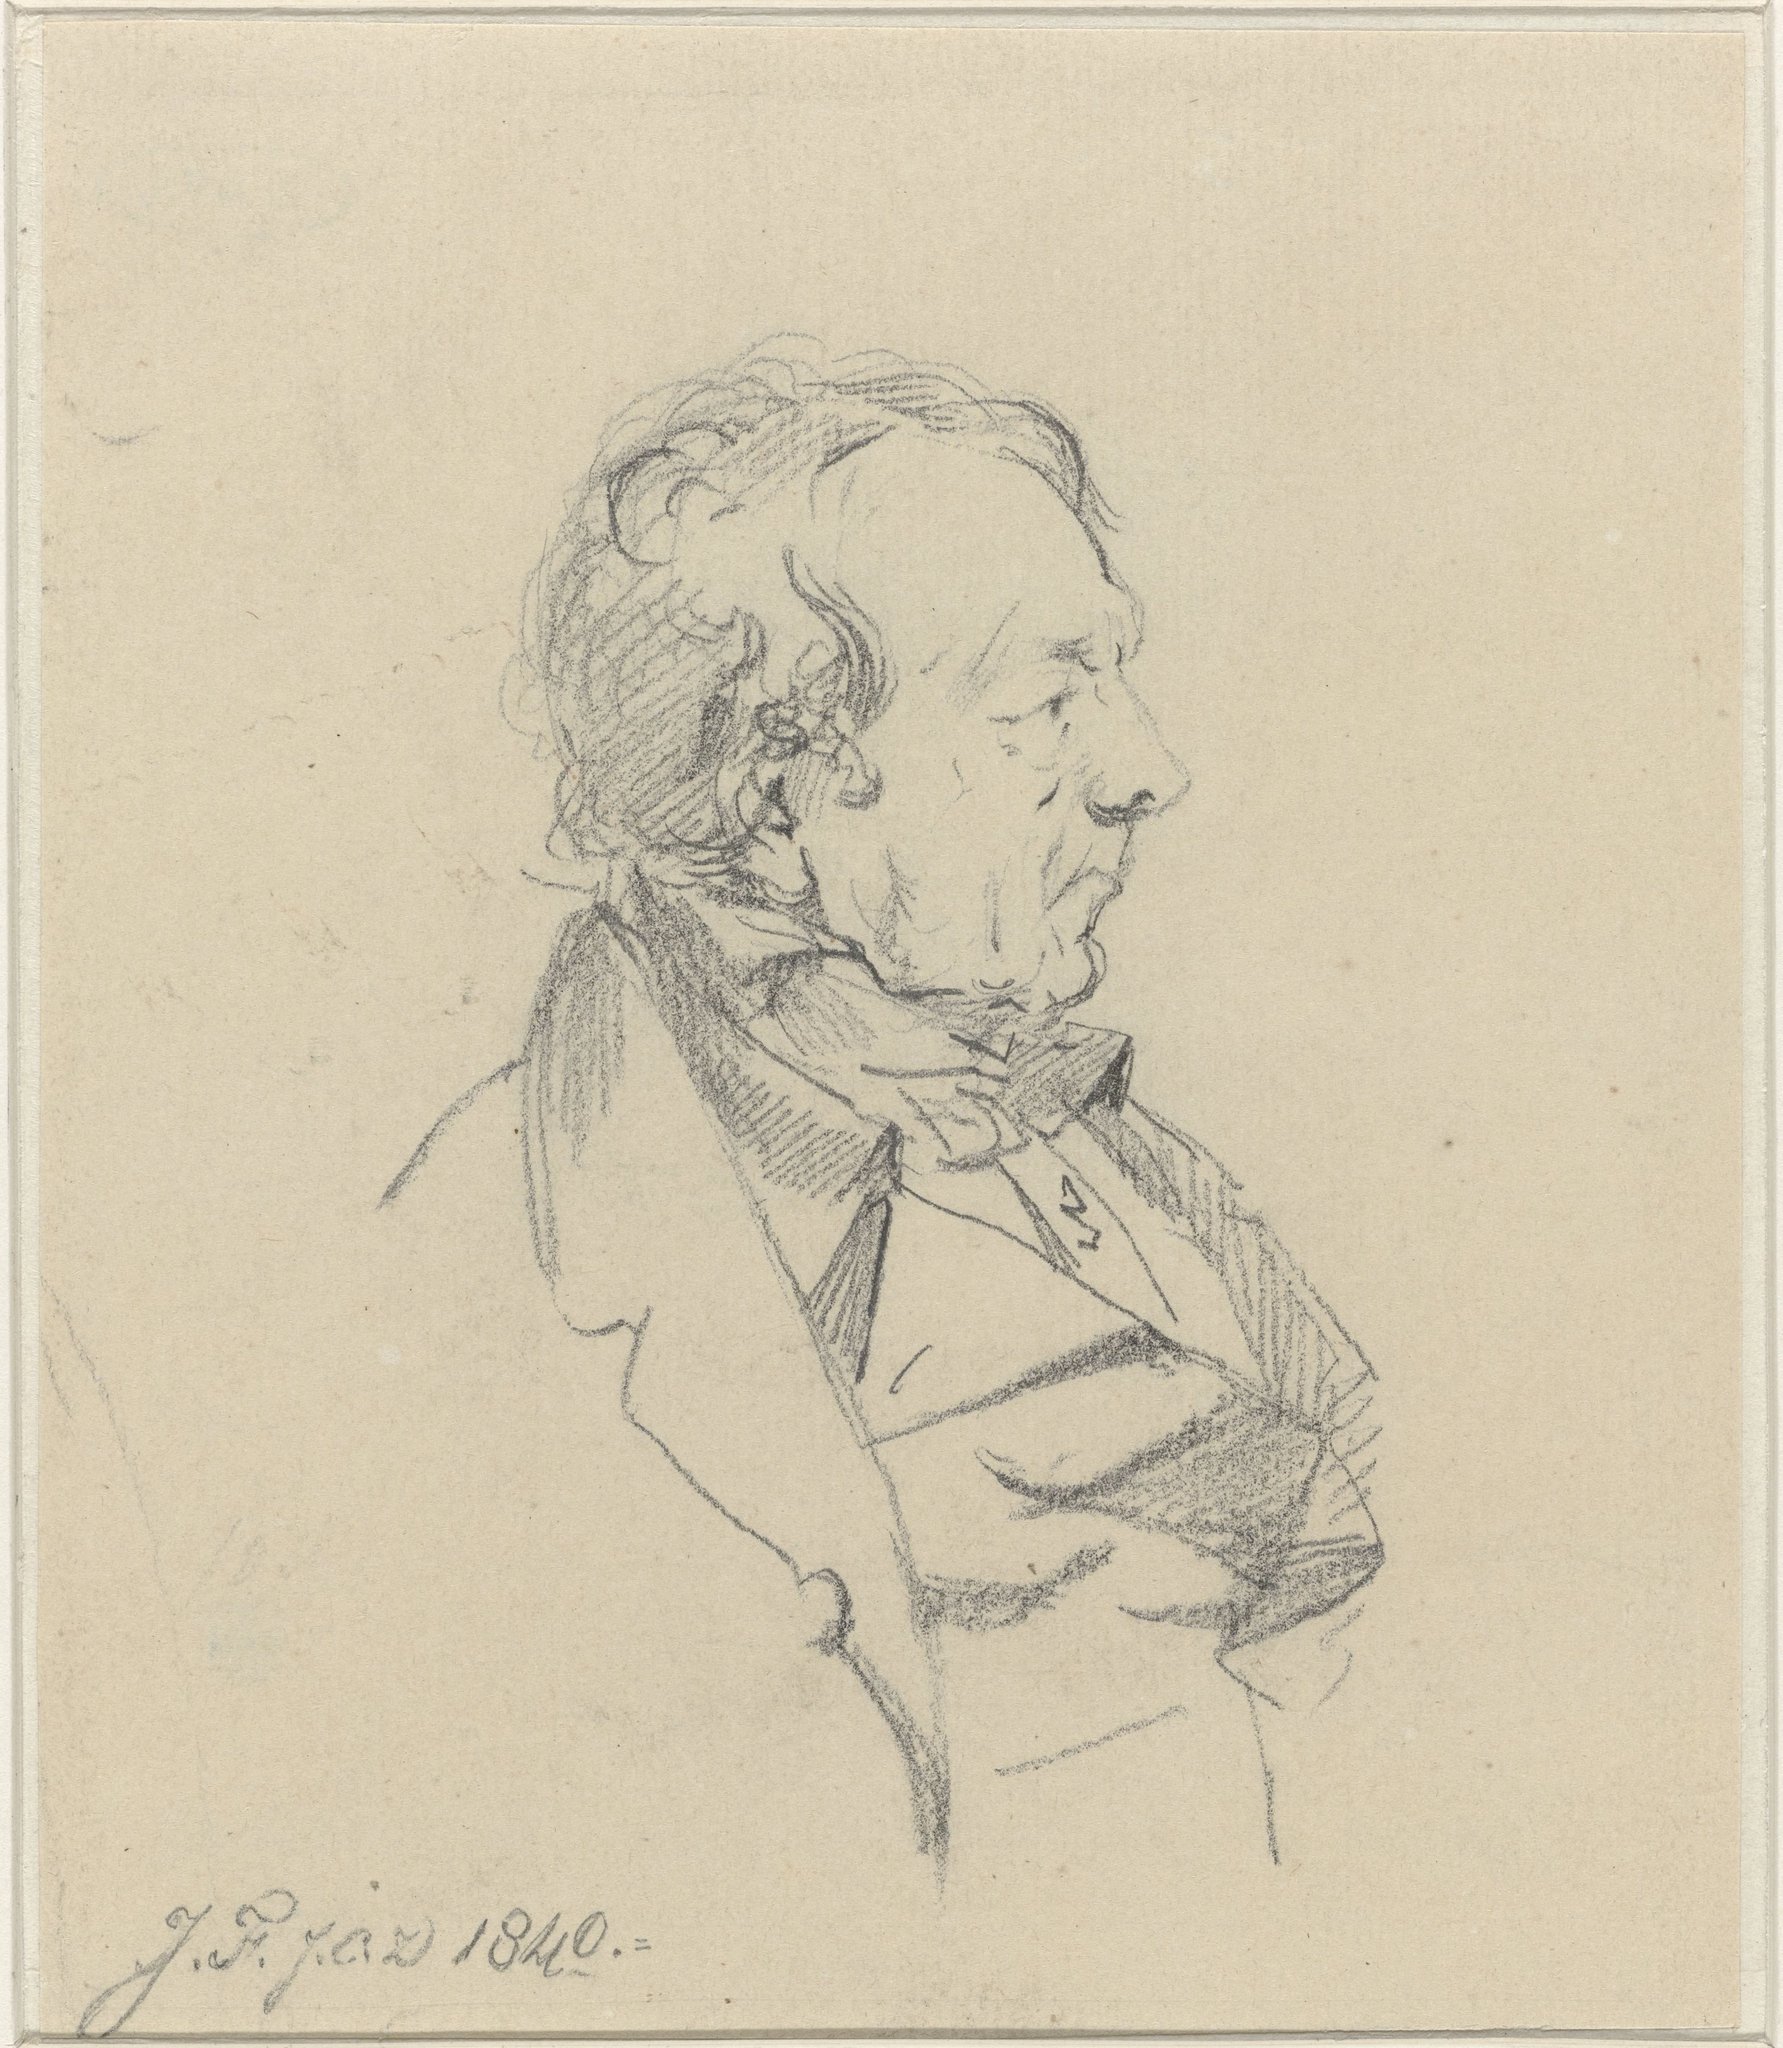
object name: drawing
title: Portret van Louis Moritz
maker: jan fabius czn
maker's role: draughtsman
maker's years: 1820-1889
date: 1840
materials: chalk, paper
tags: the hague, amsterdam, painter, print maker, draughtsman, louis moritz, historical persons, portrait, self-portrait of artist